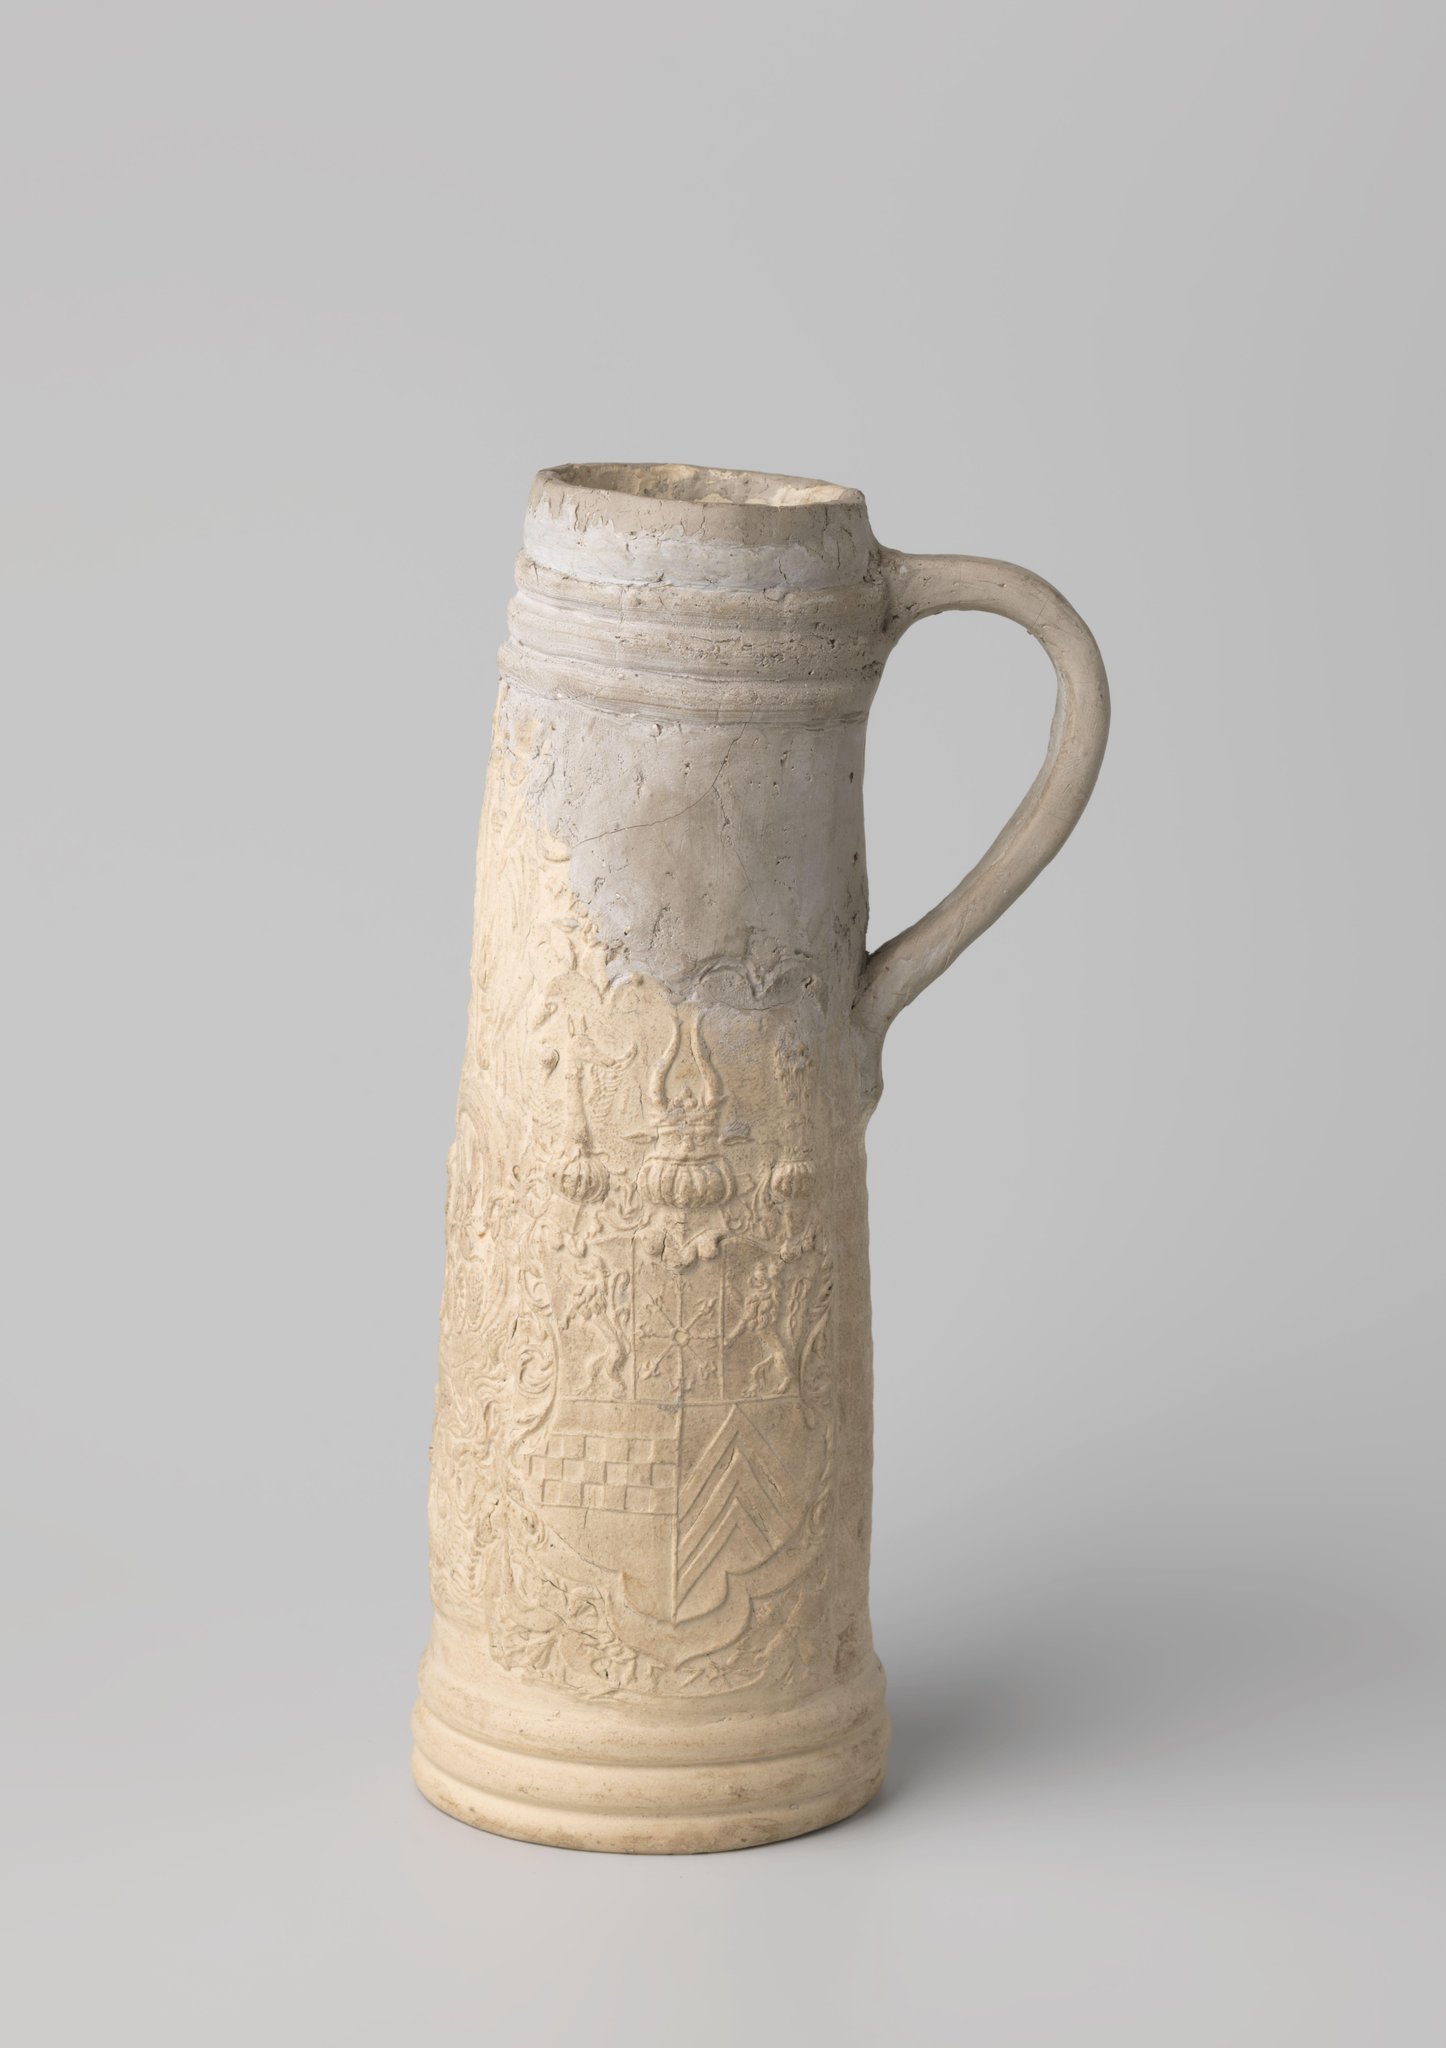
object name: schnelle, snel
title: Tankard (schnelle) with the life of Jonas and two coats of arms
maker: christian knütgen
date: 1574-1600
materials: glaze, stoneware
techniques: firing, forming, relief, turning, vitrification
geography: siegburg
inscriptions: mark: ‘K’, inscription: ‘HERZOG ZU WIRTENBERG’, date: ‘1574’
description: Kruik (schnelle) van steengoed met een cilindrisch, iets taps toelopend lichaam en C-vormig oor. Profielen boven de voet en onder de rand. Op het lichaam in reliëf een gedrukte en opgelegde decoratie van een scène uit het leven van Jonas met het opschrift 'IONA' tussen twee wapens. Onder het linker wapen het opschrift 'HERZOG ZU WIRTENBERG'; rechts het wapen van Gulik, Kleef en Berg met de datum '1574' en het merk 'K.'. Siegburg.